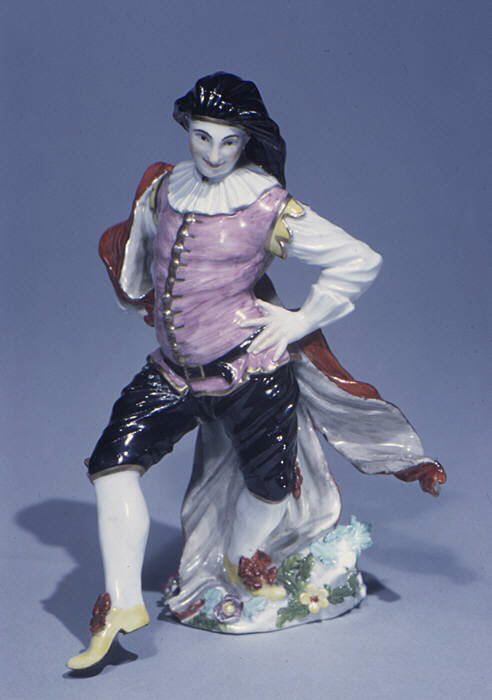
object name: figure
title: Mezzetin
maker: meissen manufactory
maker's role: manufactory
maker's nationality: german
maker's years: 1710-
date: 1740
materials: hard paste porcelain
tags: men